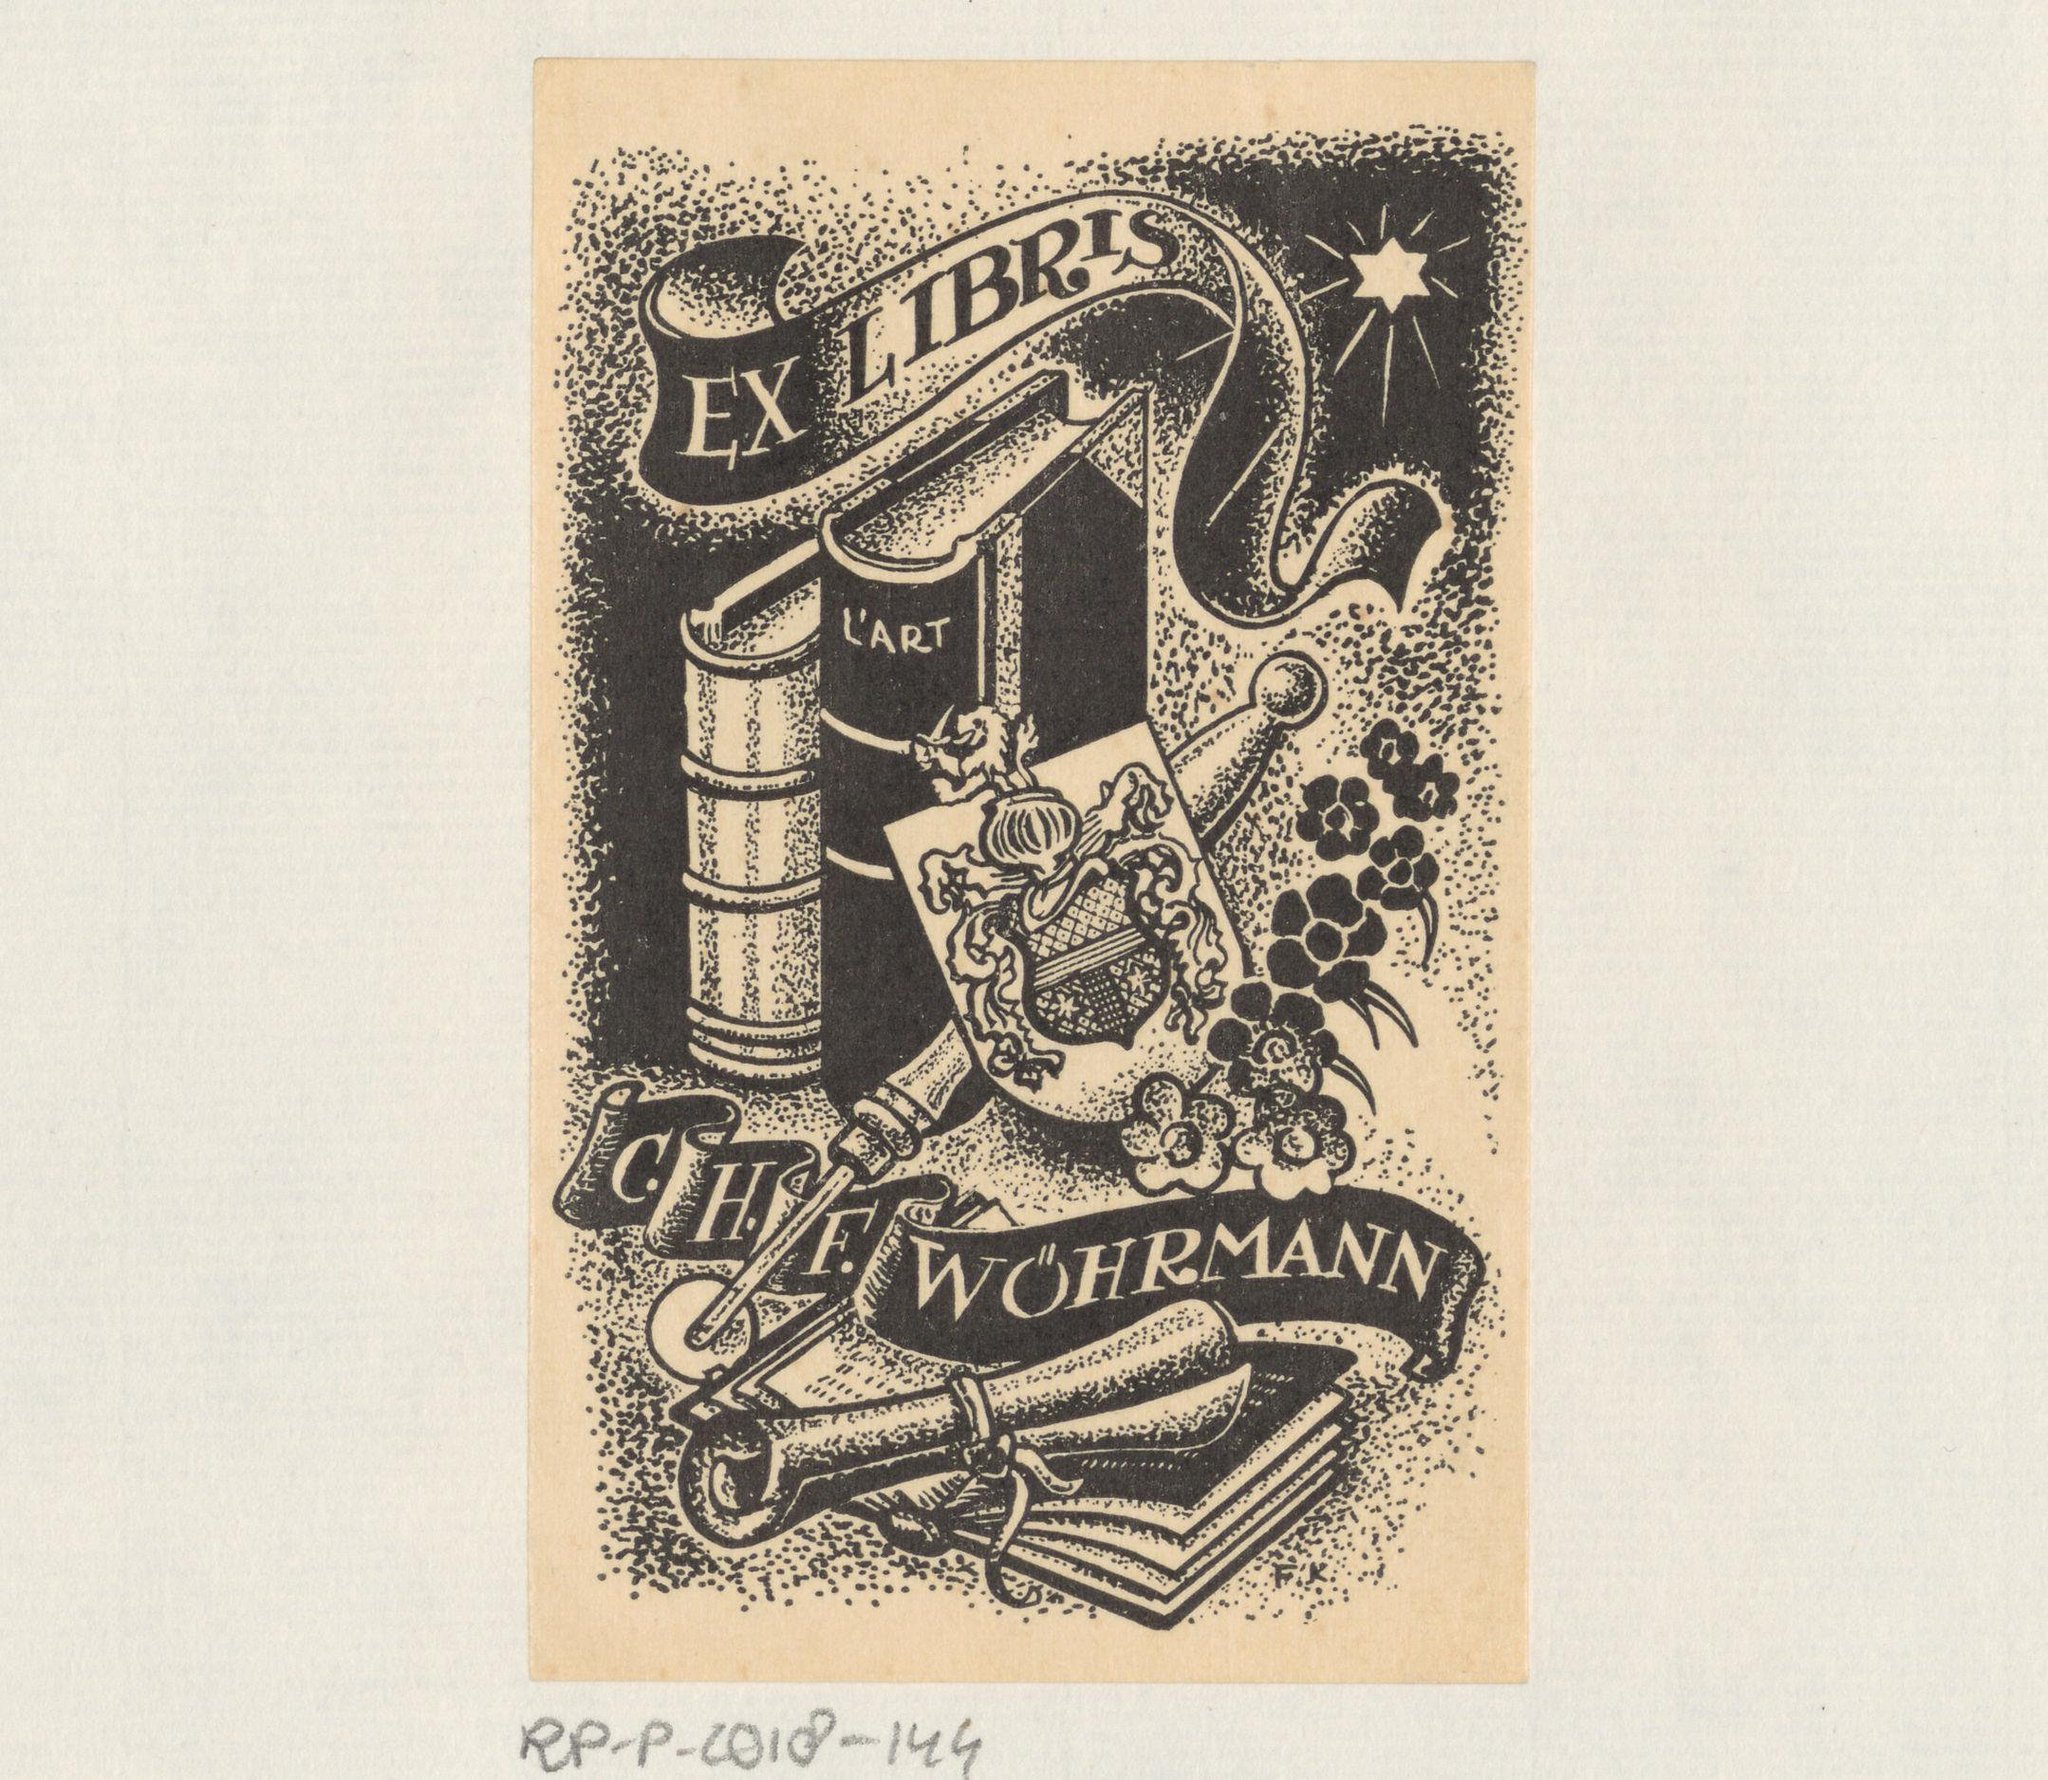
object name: bookplate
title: Ex libris van C.H.F. Wöhrmann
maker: Anonymous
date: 1900-1999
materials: paper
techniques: lithograph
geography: netherlands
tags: bookbinding, book, armorial bearing, heraldry